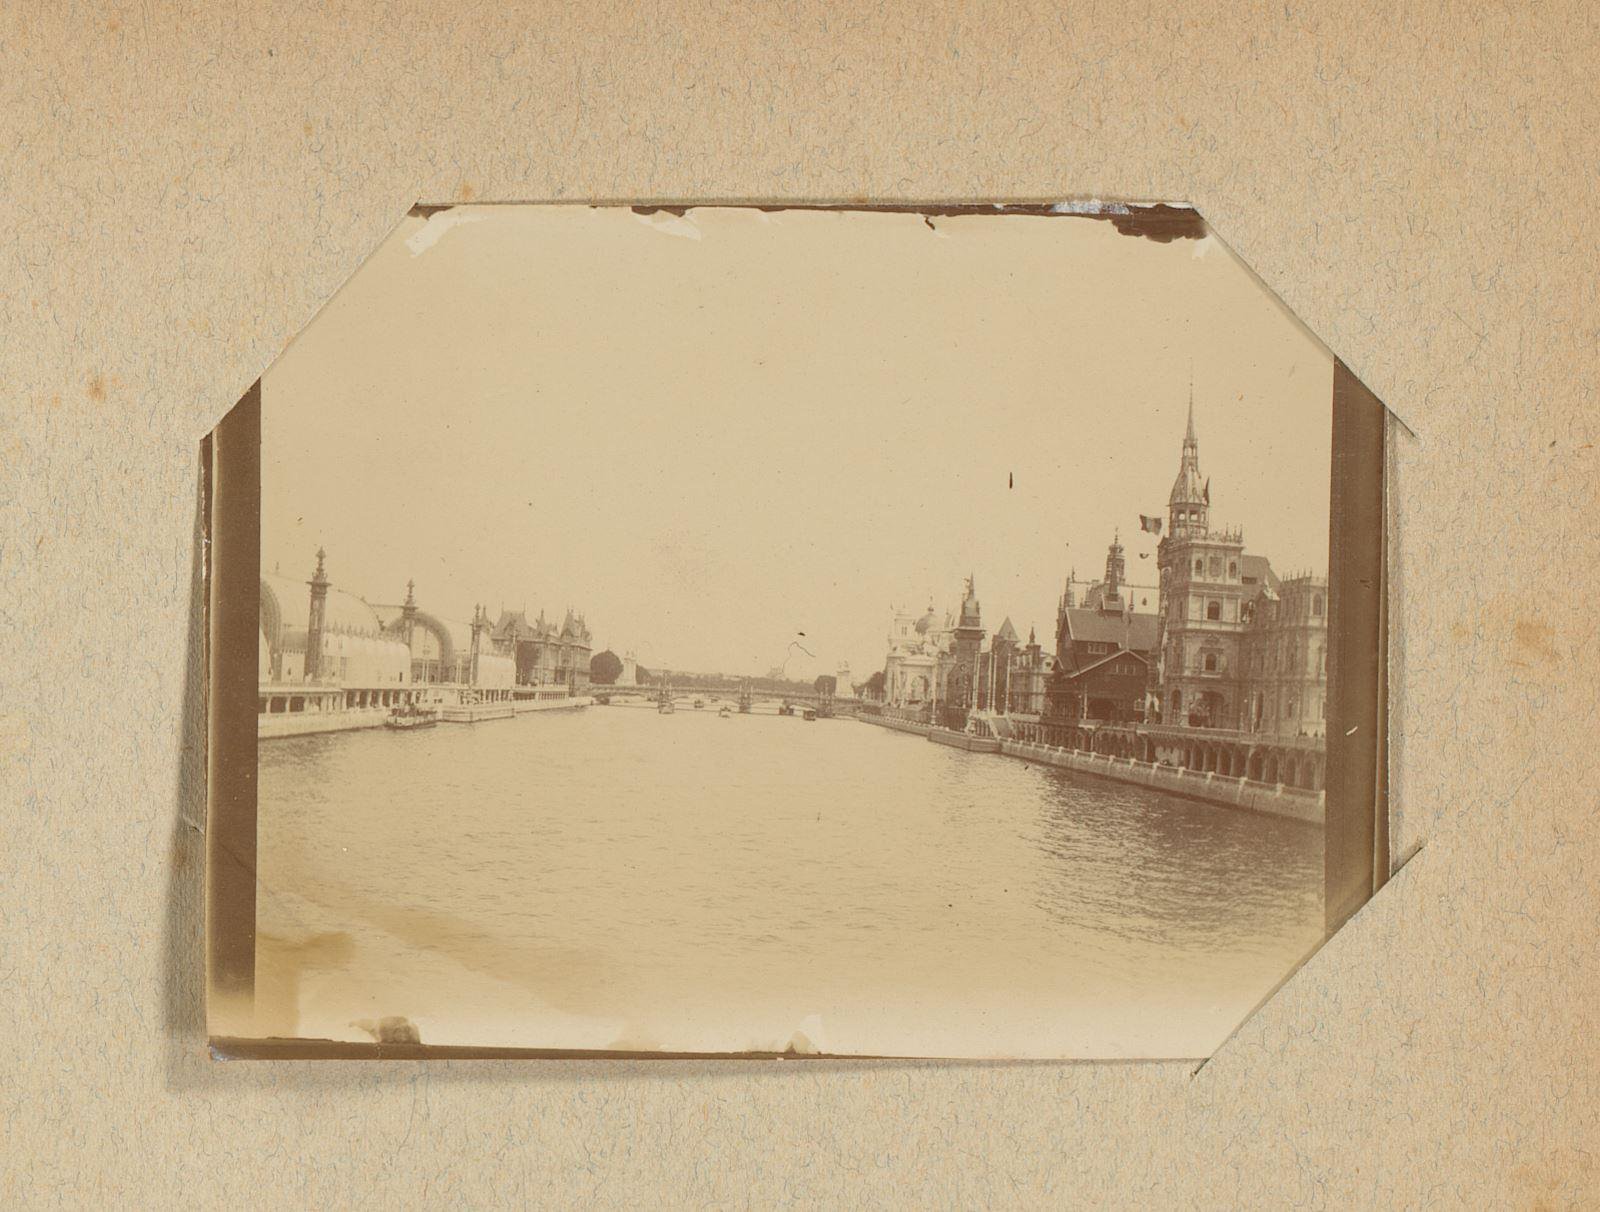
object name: photograph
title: Gezicht op de Seine tijdens de Wereldtentoonstelling van 1900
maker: Anonymous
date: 1900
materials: paper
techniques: gelatin silver print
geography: paris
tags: world fair, world exhibition, paris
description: Over de foto is een ander negatief afgedrukt van een voorstelling van bomen.